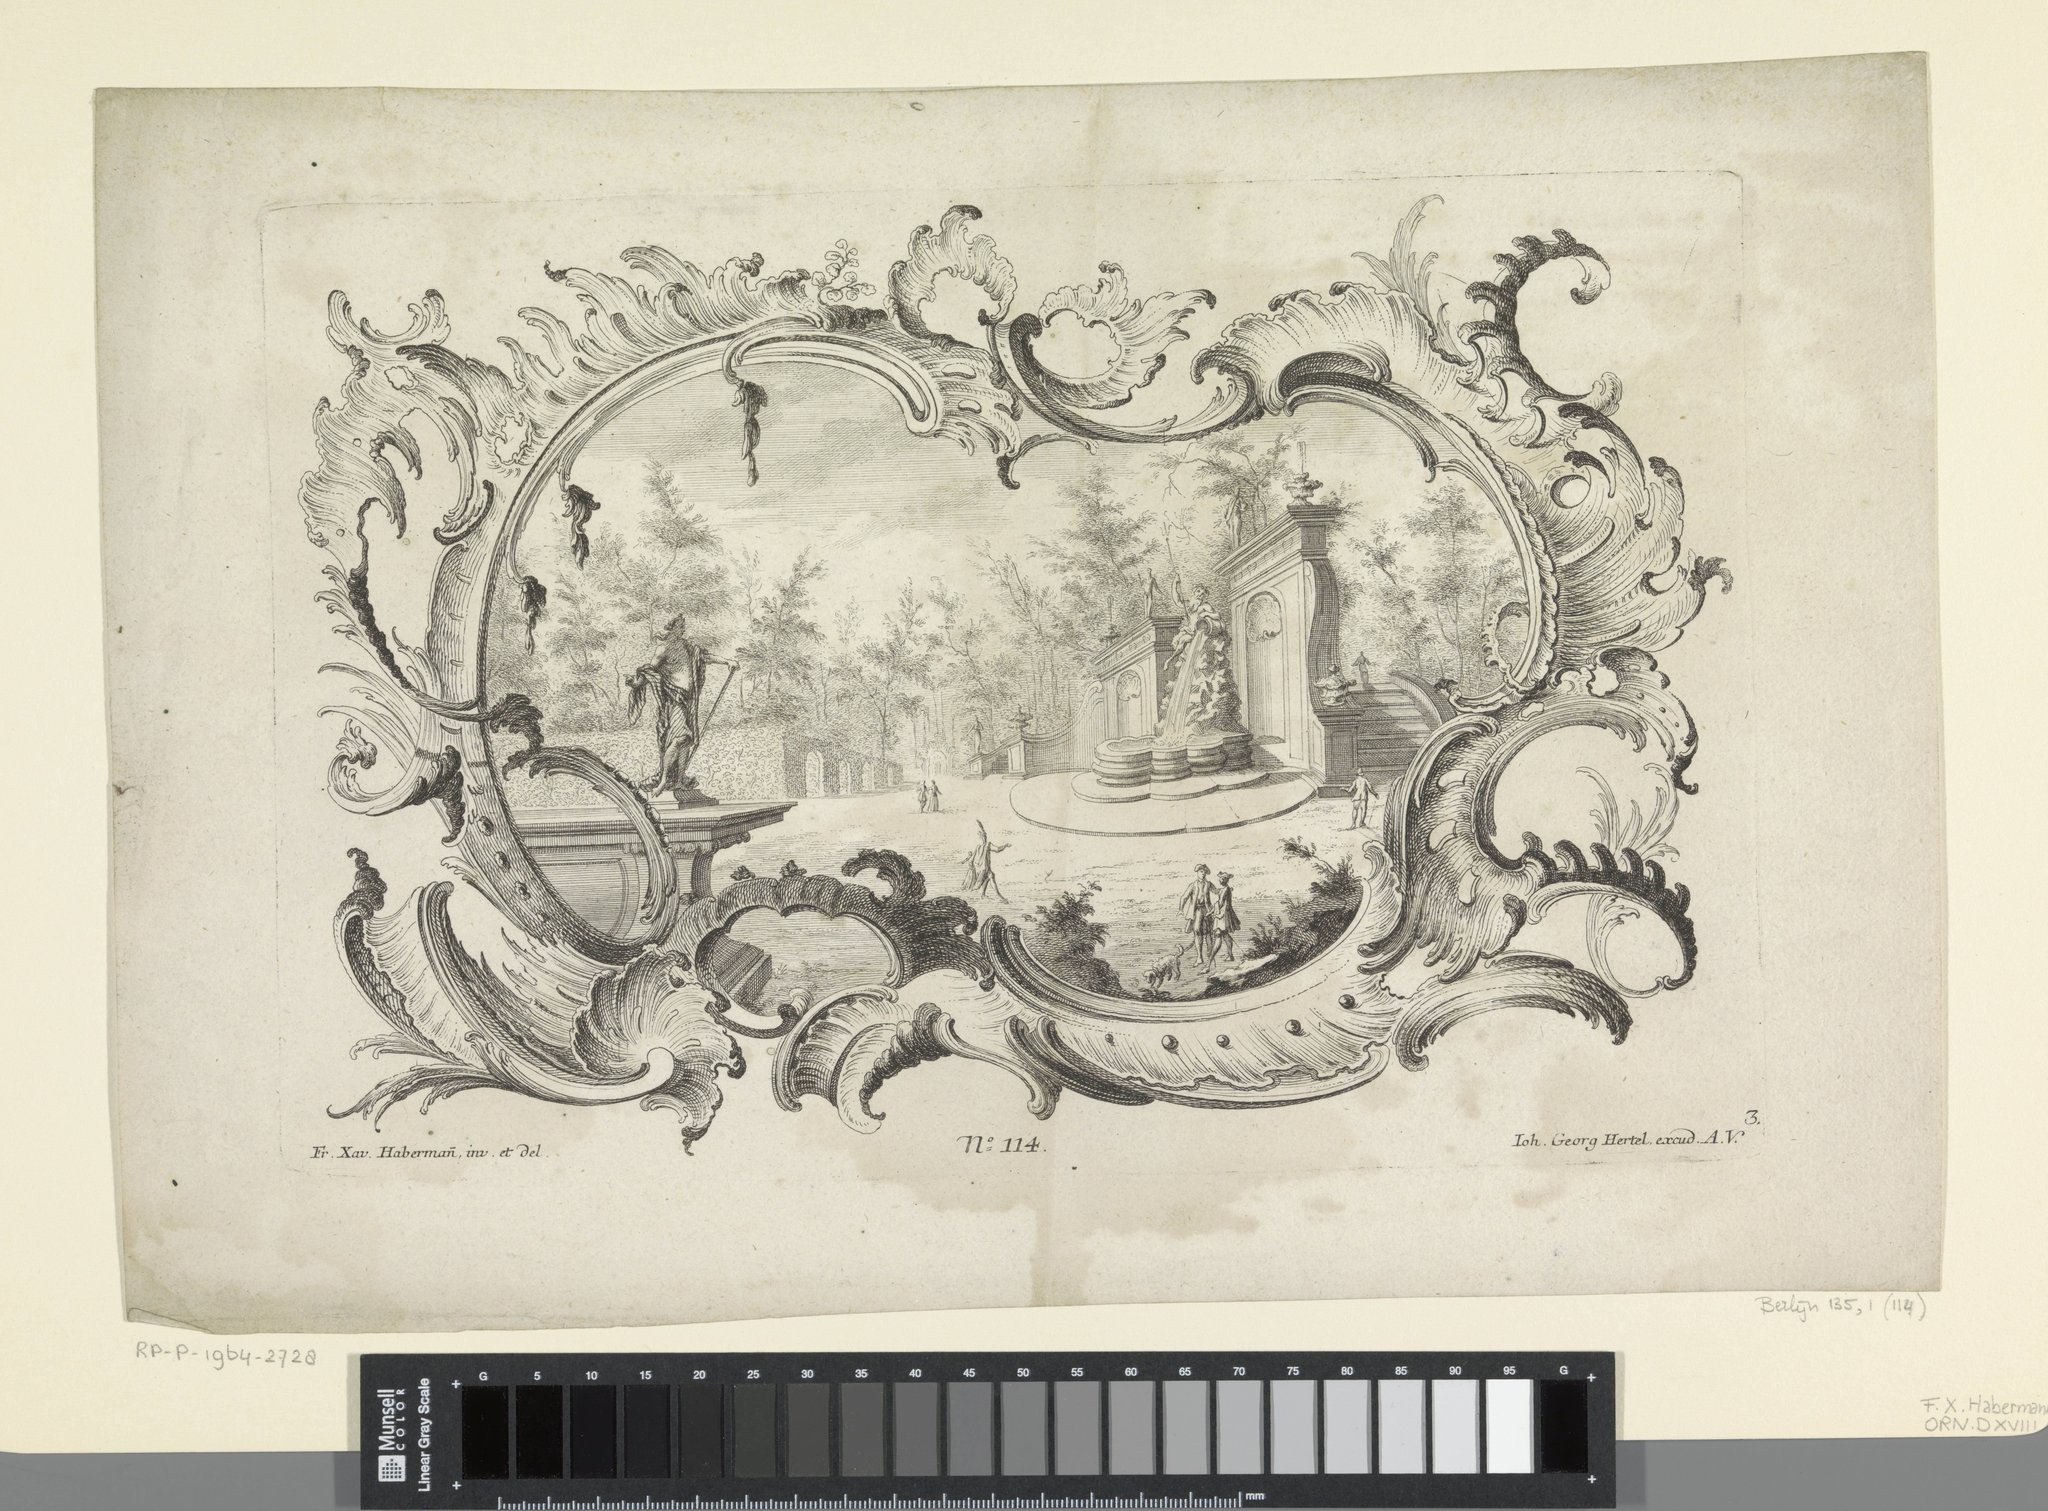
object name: ornament print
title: Landschap in rocaille cartouche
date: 1731-1775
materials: paper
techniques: etching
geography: augsburg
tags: rocaille ornament, garden fountain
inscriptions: collector's mark: Lugt 2228, collector's mark: Lugt 2760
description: Figuren in een tuin met rechts een fontein. In rocaille omlijsting. Uitgeversnummer 114.